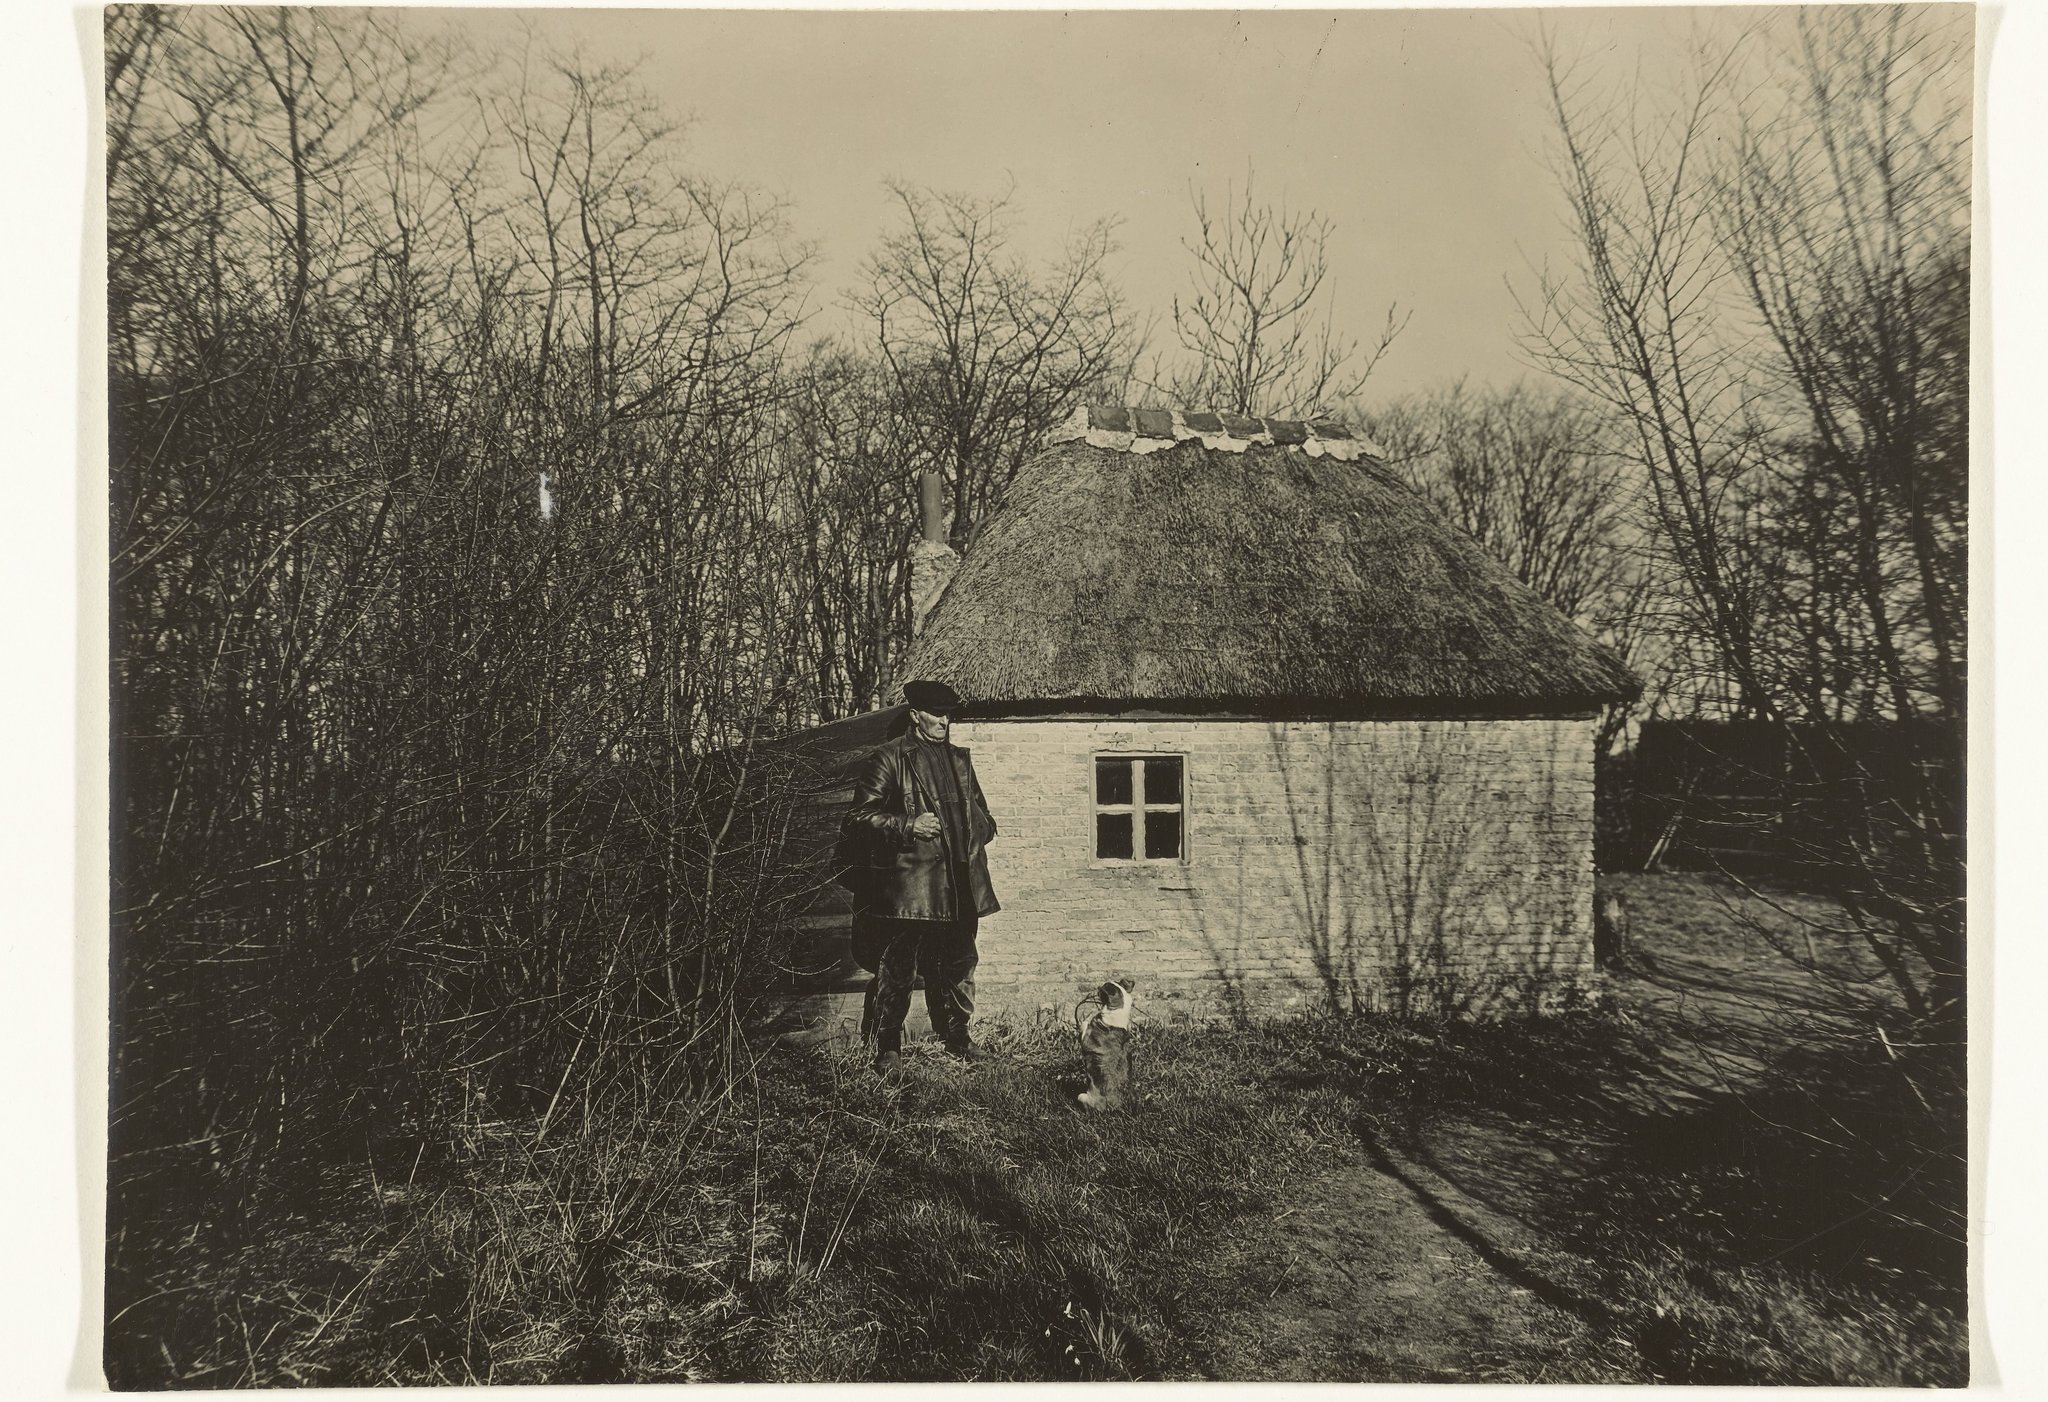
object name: photograph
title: Man met hond voor een huis of boerderij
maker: richard tepe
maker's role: fotograaf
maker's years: 1864-1952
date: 1900-1930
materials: cardboard, paper, photographic support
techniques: gelatin silver print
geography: netherlands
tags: dog